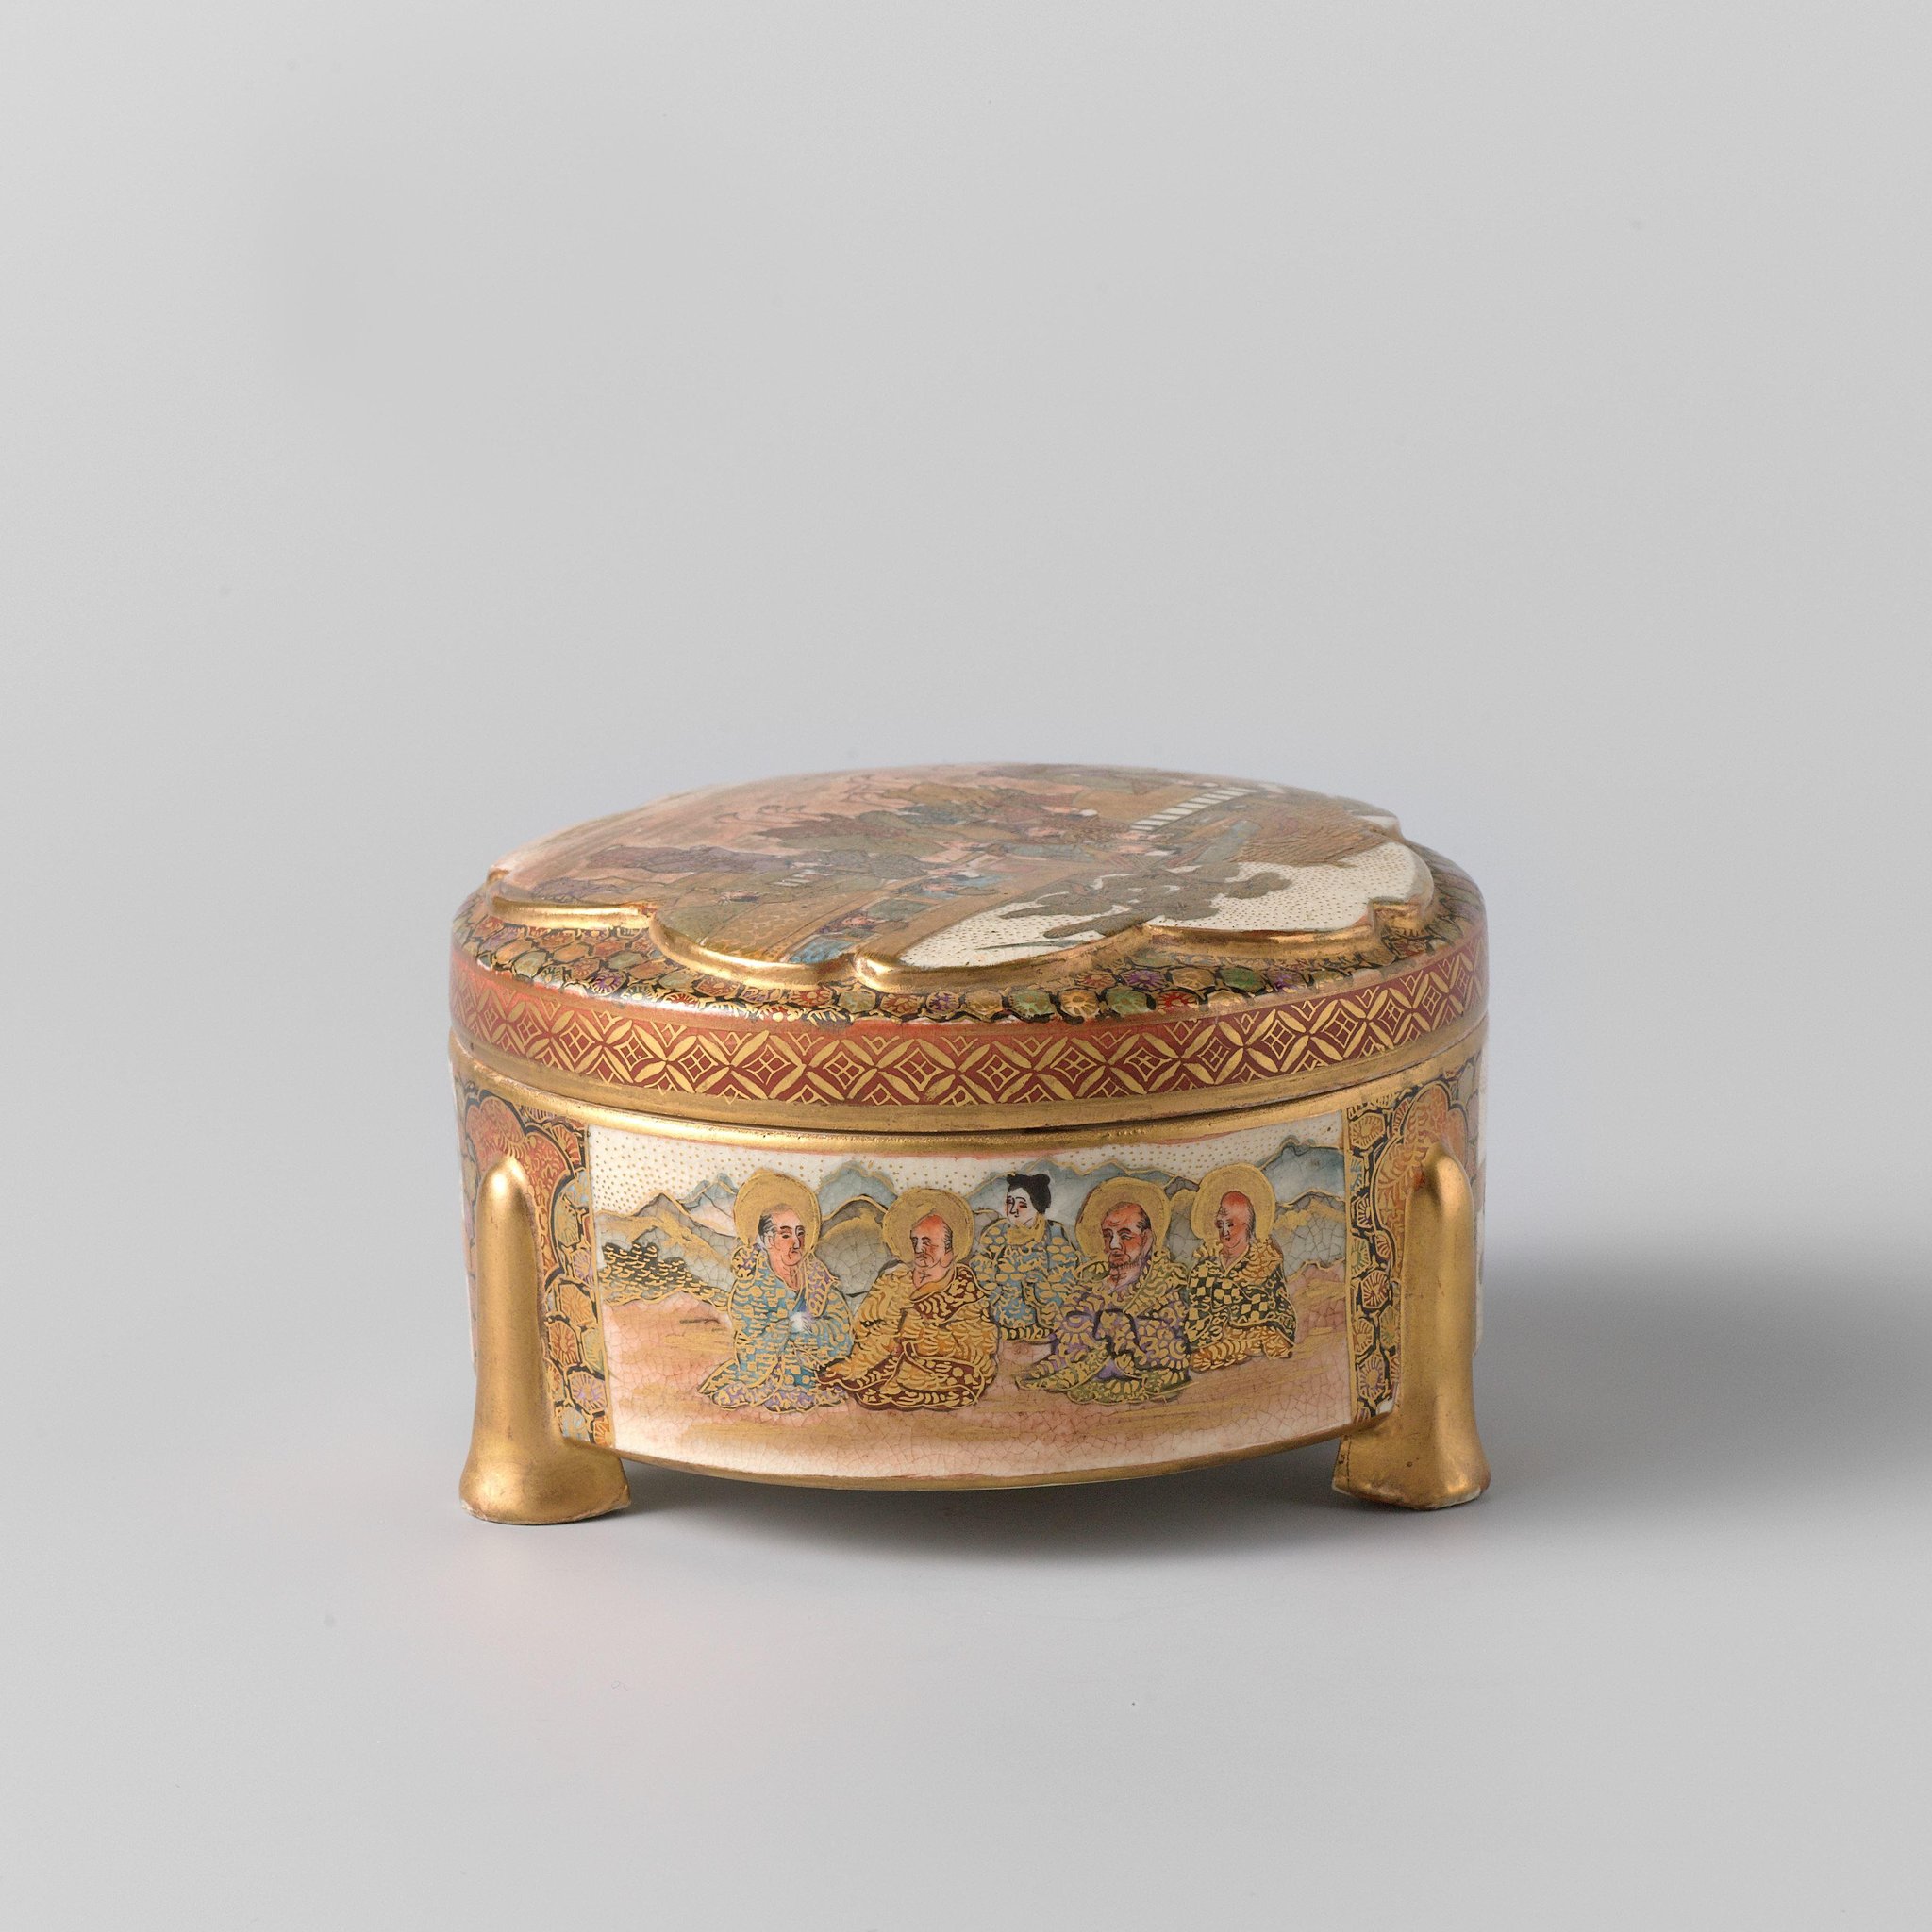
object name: box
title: Round box with figures on a terras or in a landscape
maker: Anonymous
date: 1800-1899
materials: glaze, gold, paint, stoneware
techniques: firing, gilding, turning, vitrification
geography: satsuma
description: Ronde doos van steengoed op drie korte poten, beschilderd op het glazuur in blauw, rood, groen, paars, bruin, zwart en goud. Op de wand drie vakken met daarin: een groep zittende vrouwen op een terras voor een paviljoen, een groep zittende mannen op een terras voor een paviljoen, vier mannen en een vrouw zittend in een landschap. De poten zijn verguld en vanuit de wand gemodelleerd; om de poten een vak met servetwerk. Satsuma.